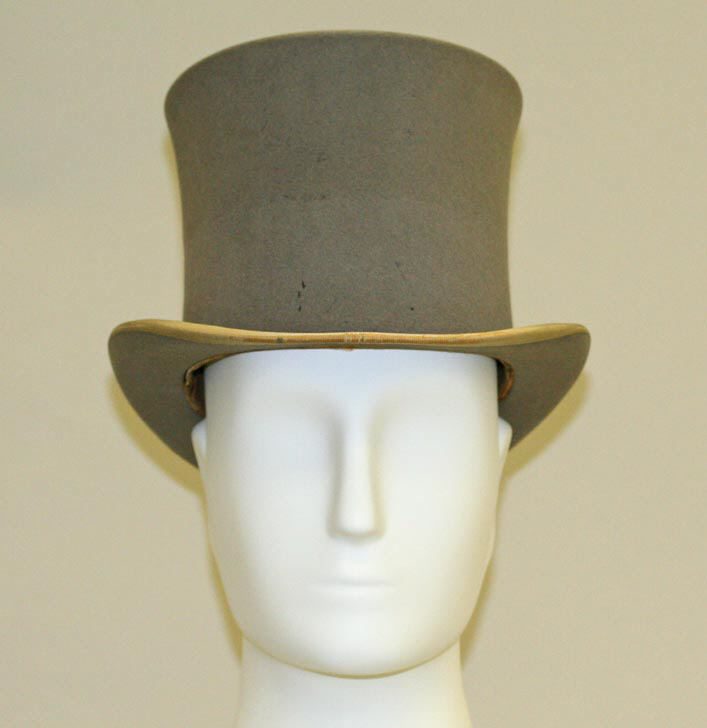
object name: hat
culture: american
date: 1870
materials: wool